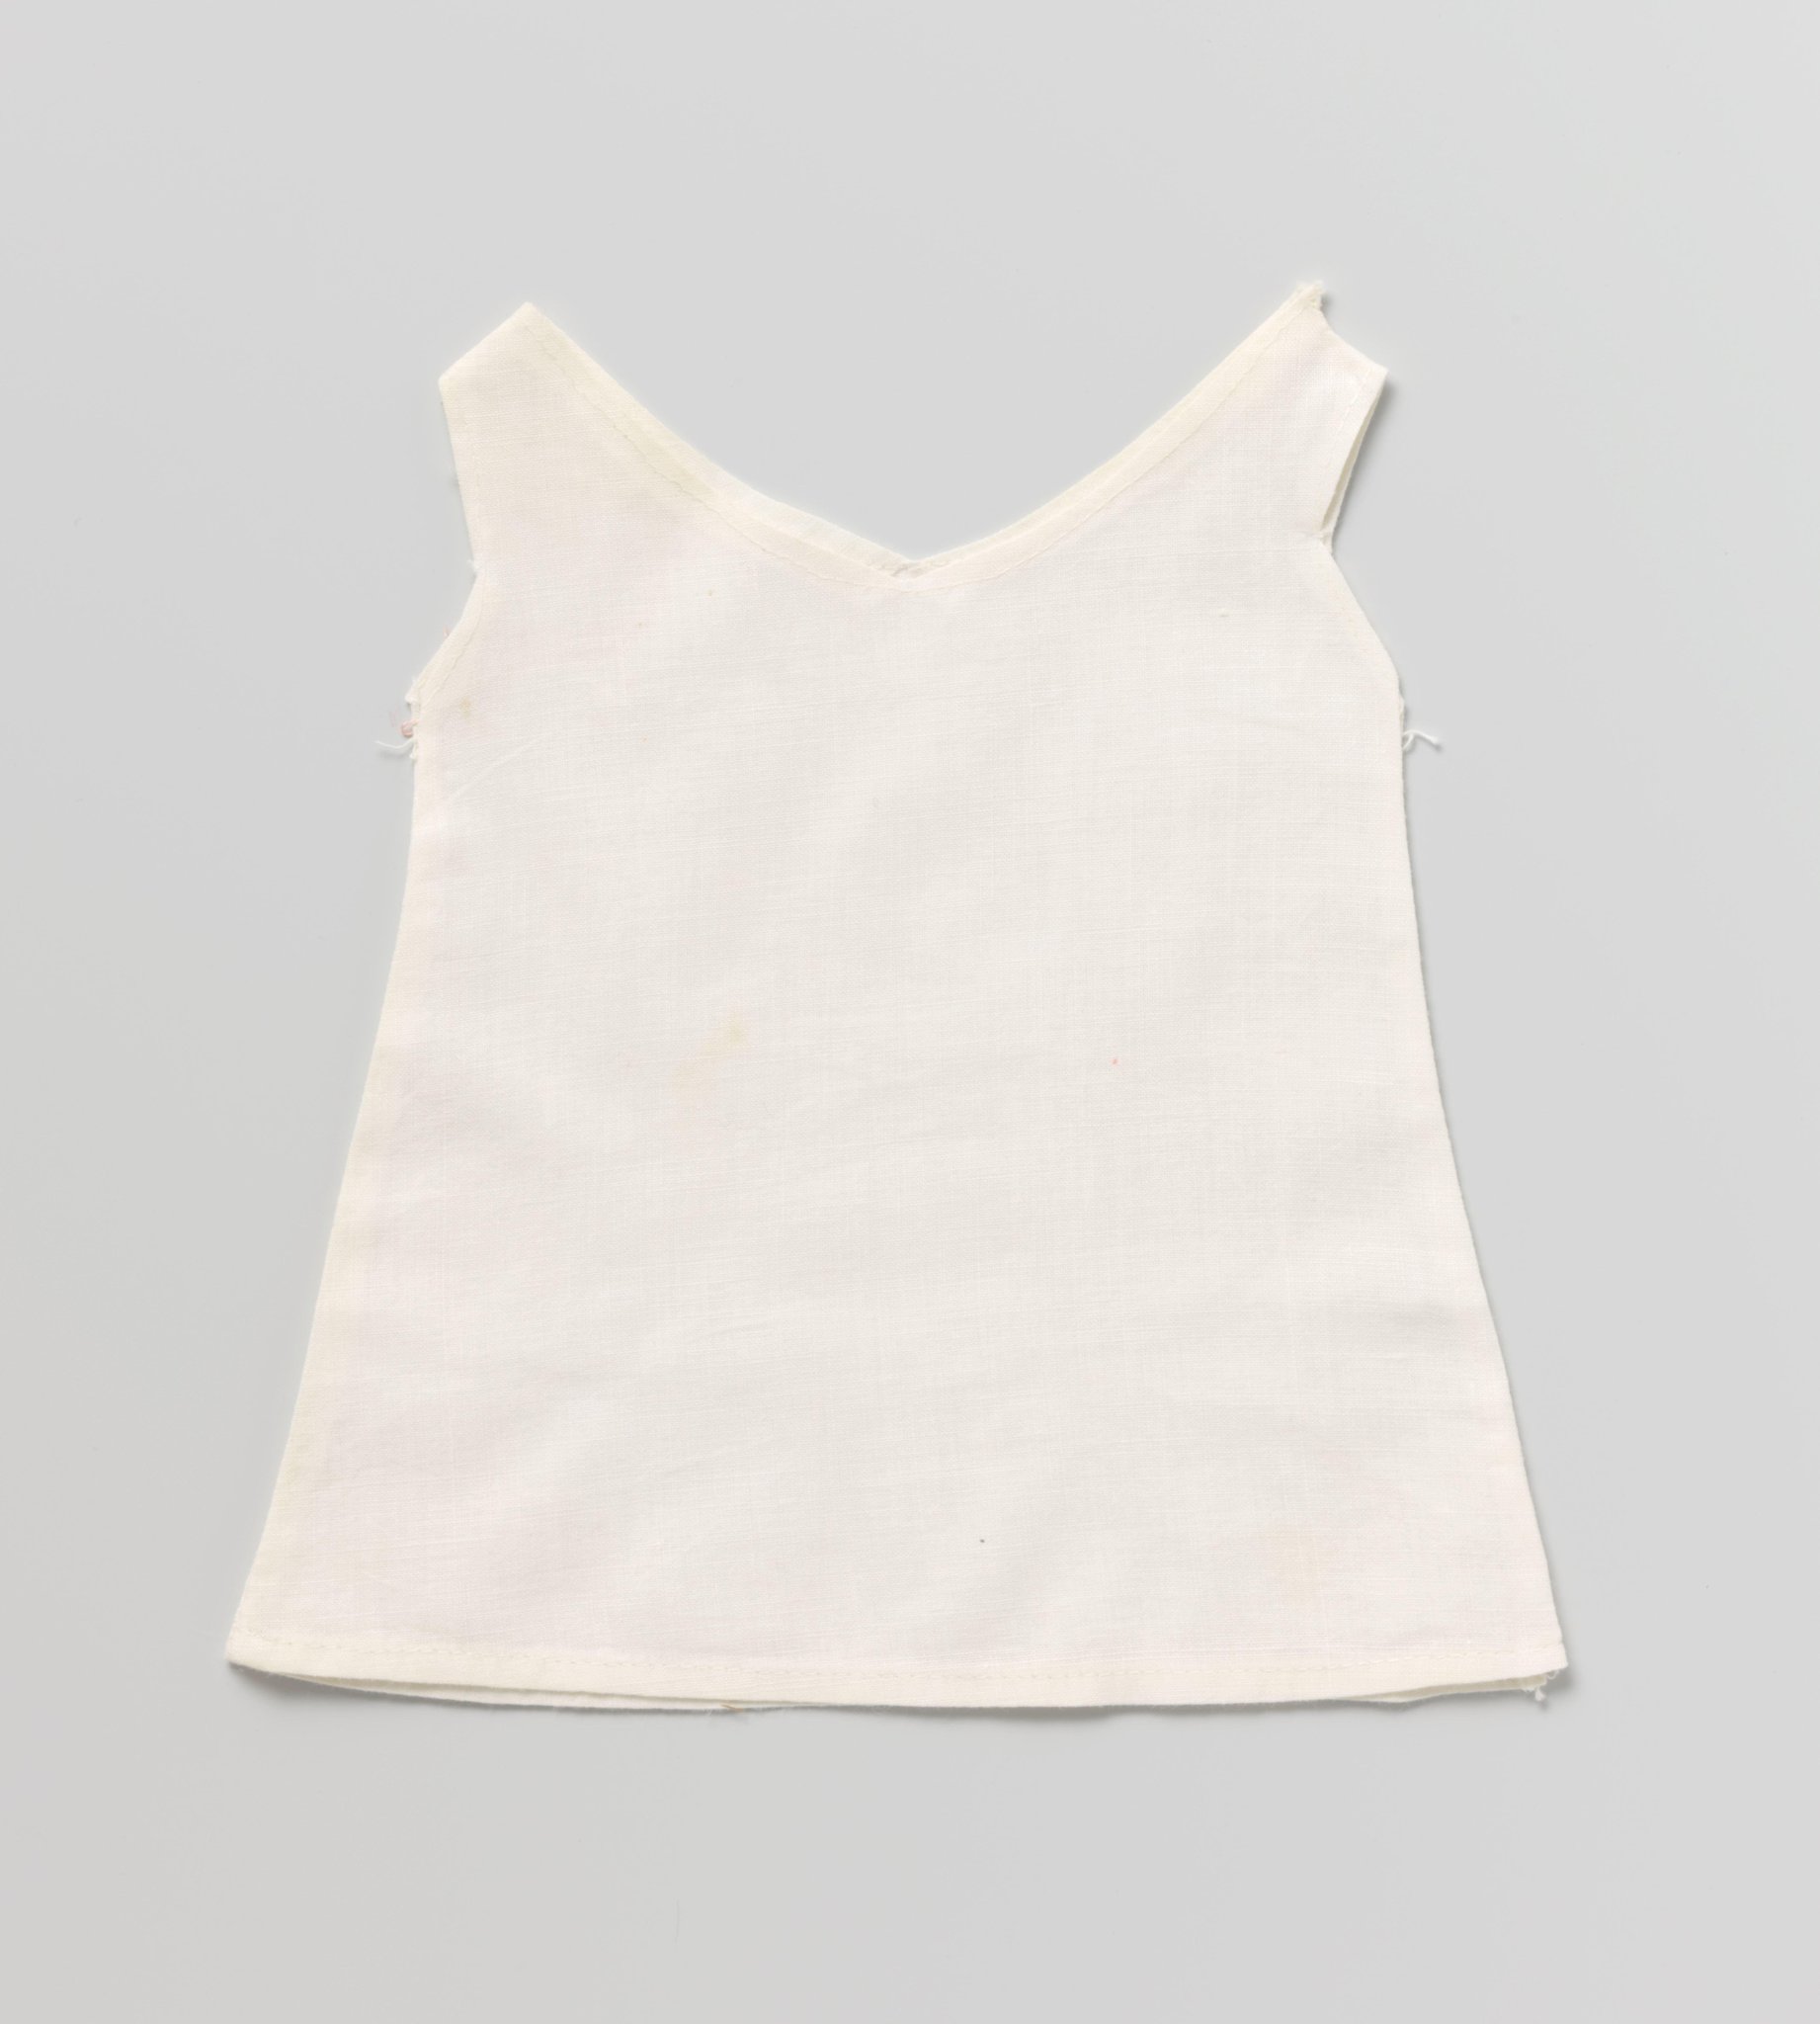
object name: chemise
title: Hemd met brede V-hals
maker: Anonymous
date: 1890-1900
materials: cotton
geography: germany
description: Hemd met brede V-hals. Behorend bij meisjesbabypop.